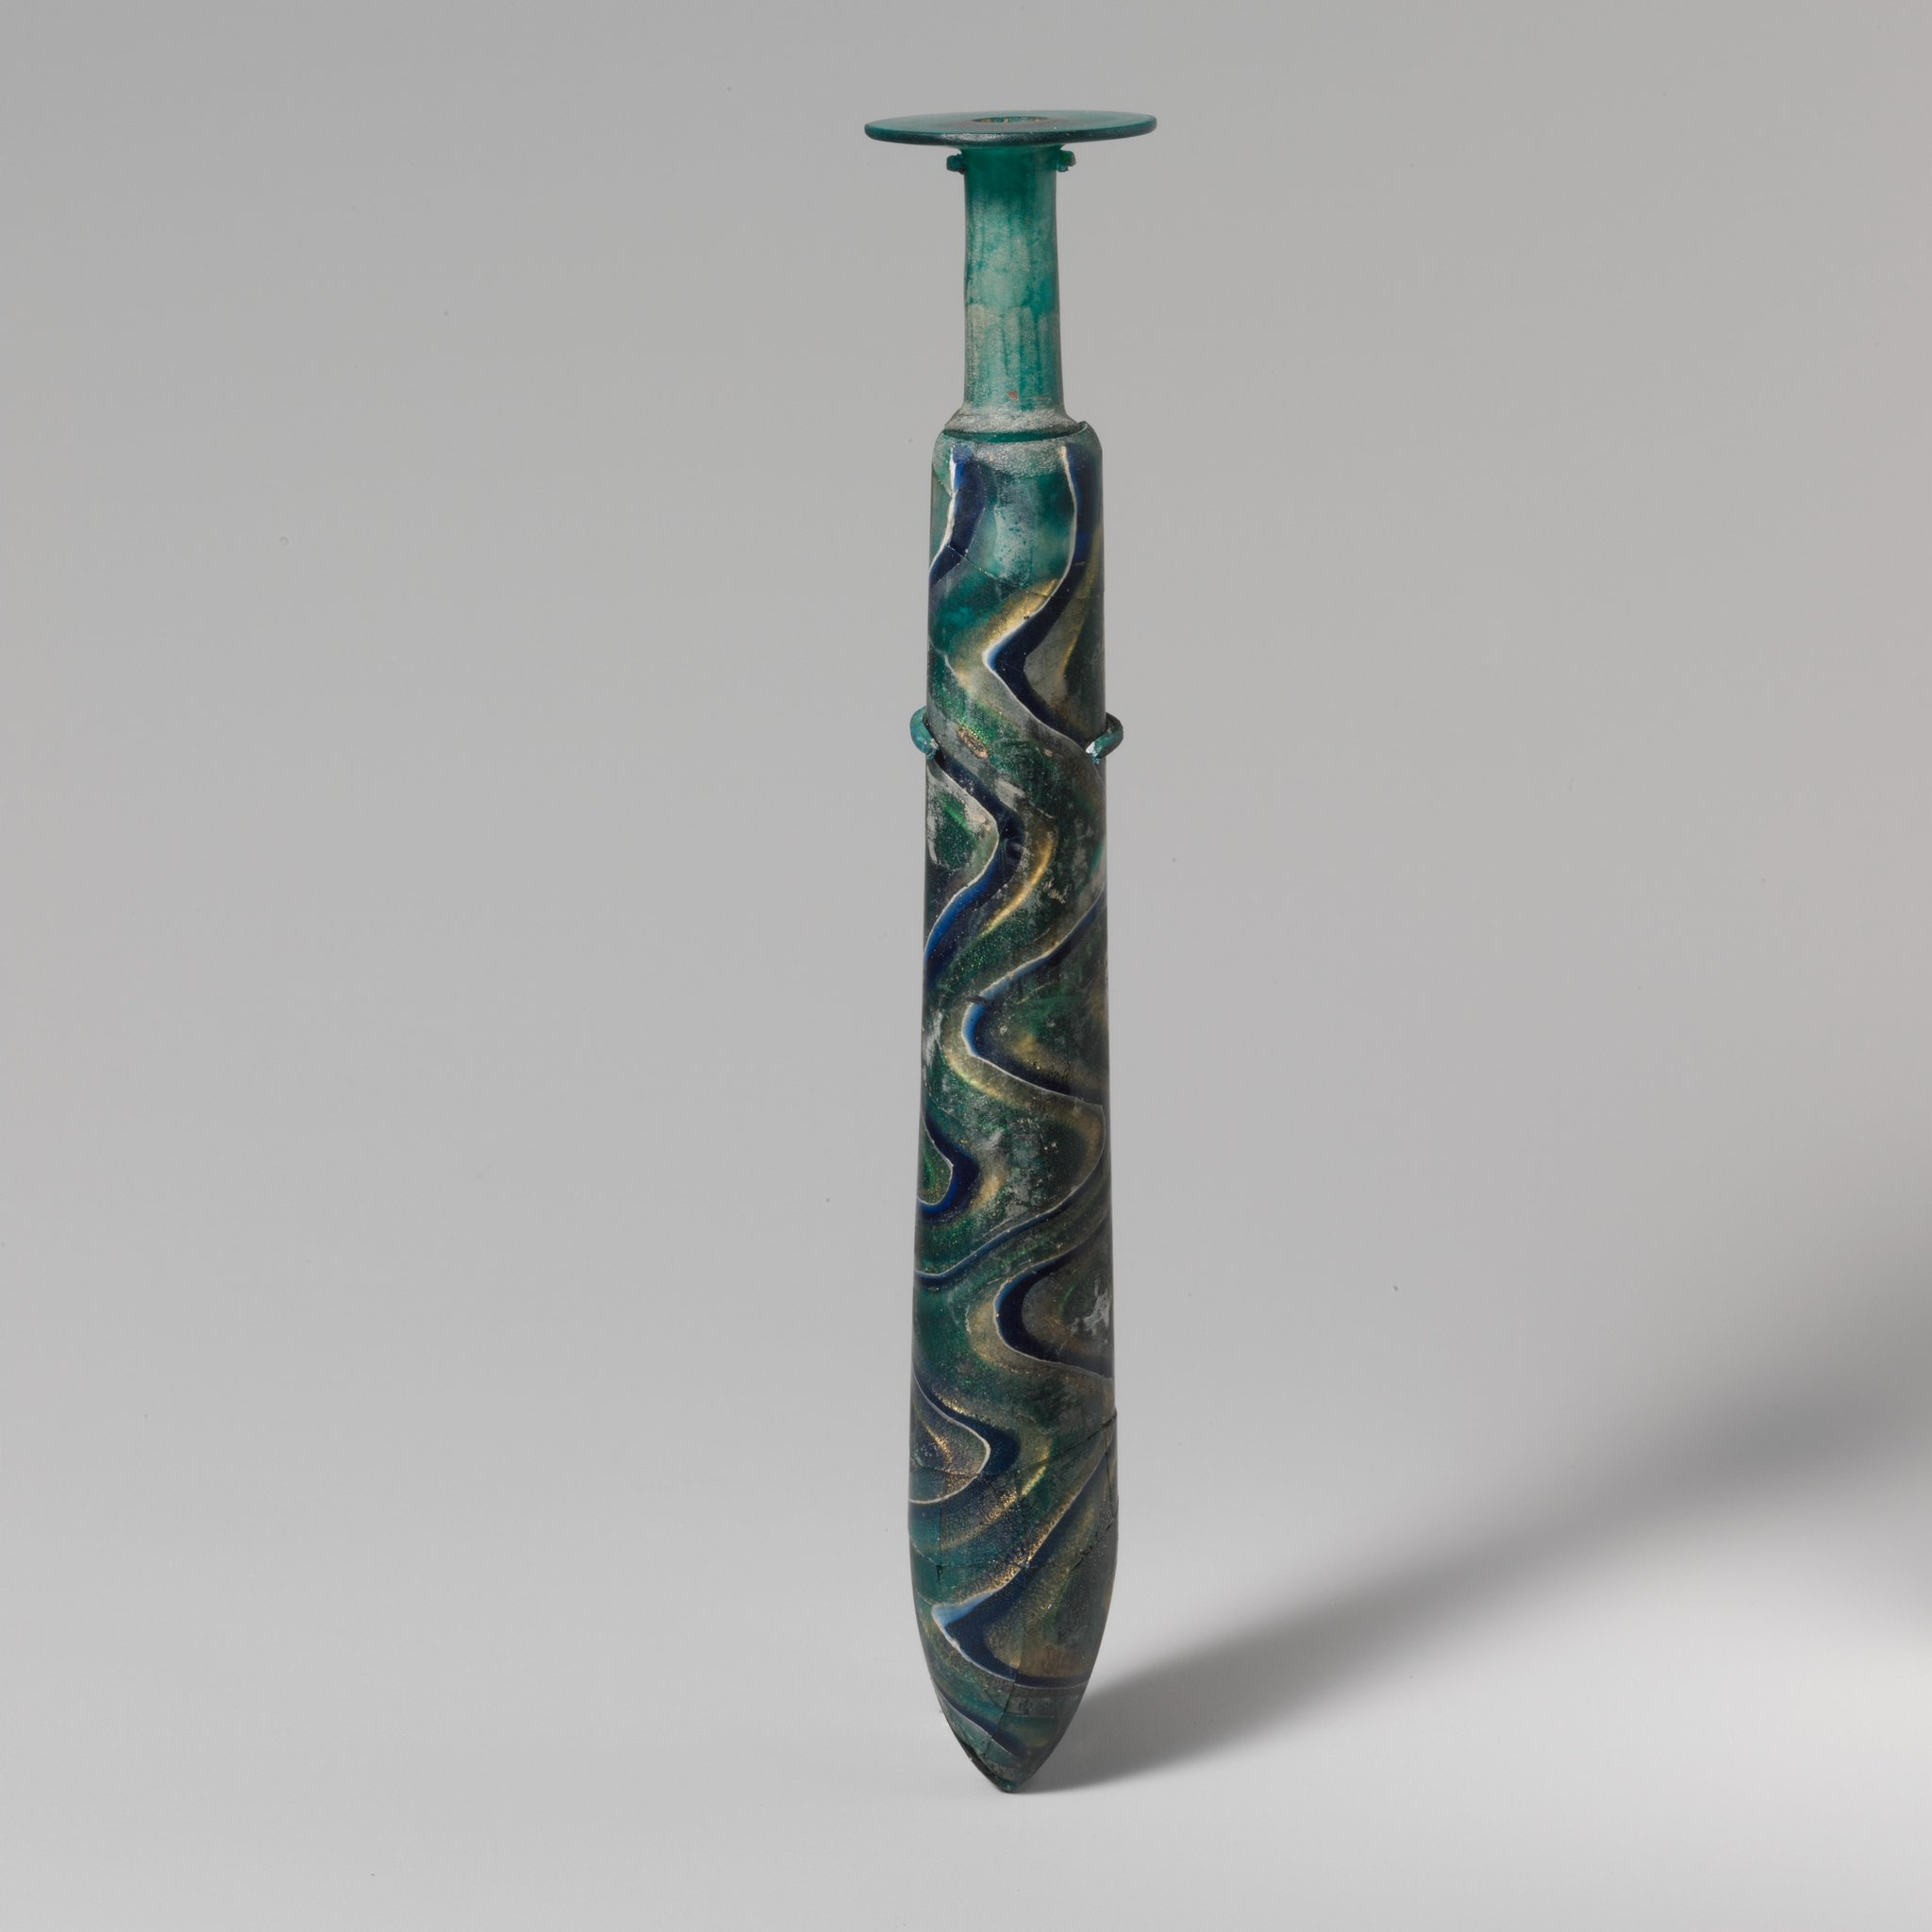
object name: alabastron, gold band mosaic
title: Glass gold-band mosaic alabastron (perfume bottle)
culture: greek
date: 100-1 BCE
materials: glass, gold leaf